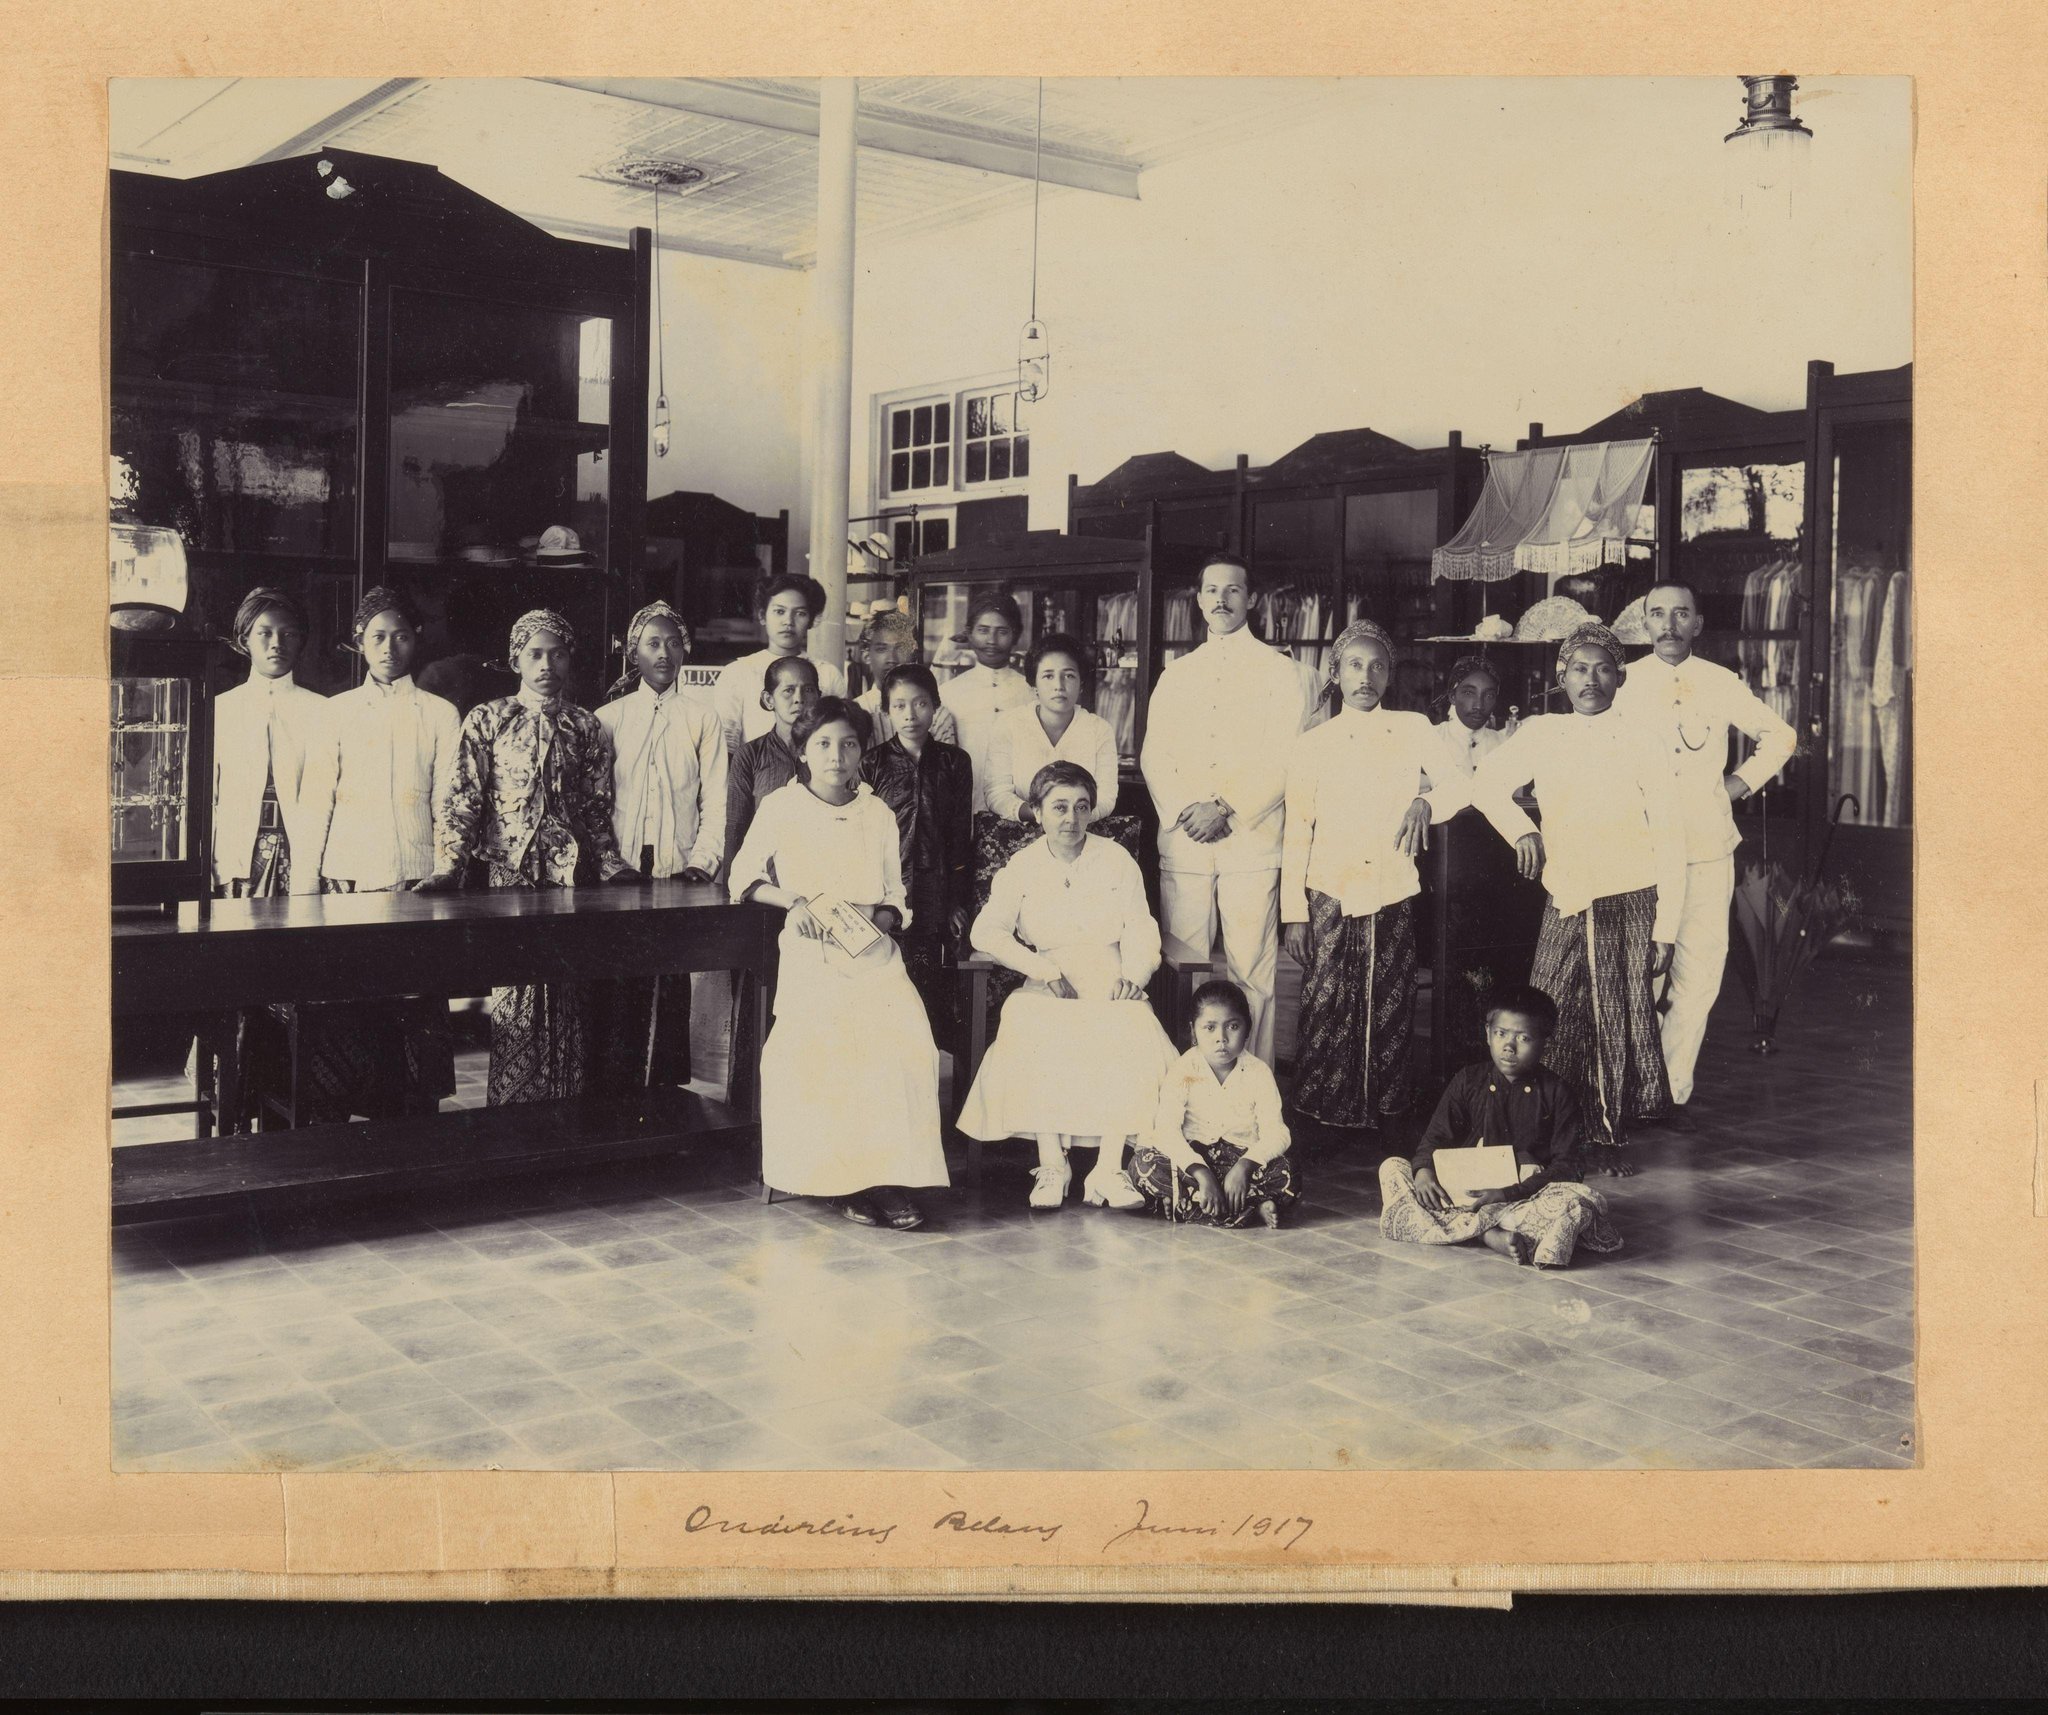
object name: photograph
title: Groepsportret van Indonesiërs en Europeanen, vermoedelijk in een pand van Handelsvereniging 'Onderling Belang' in Nederlands-Indië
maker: Anonymous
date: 1906-1917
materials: photographic support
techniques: gelatin silver print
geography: dutch east indies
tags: department store, supermarket, dutch east indies, the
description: Onderdeel van Familiealbum met foto's van een familie in de voormalige kolonie Nederlands-Indië en van een suikerfabriek in Purworejo.